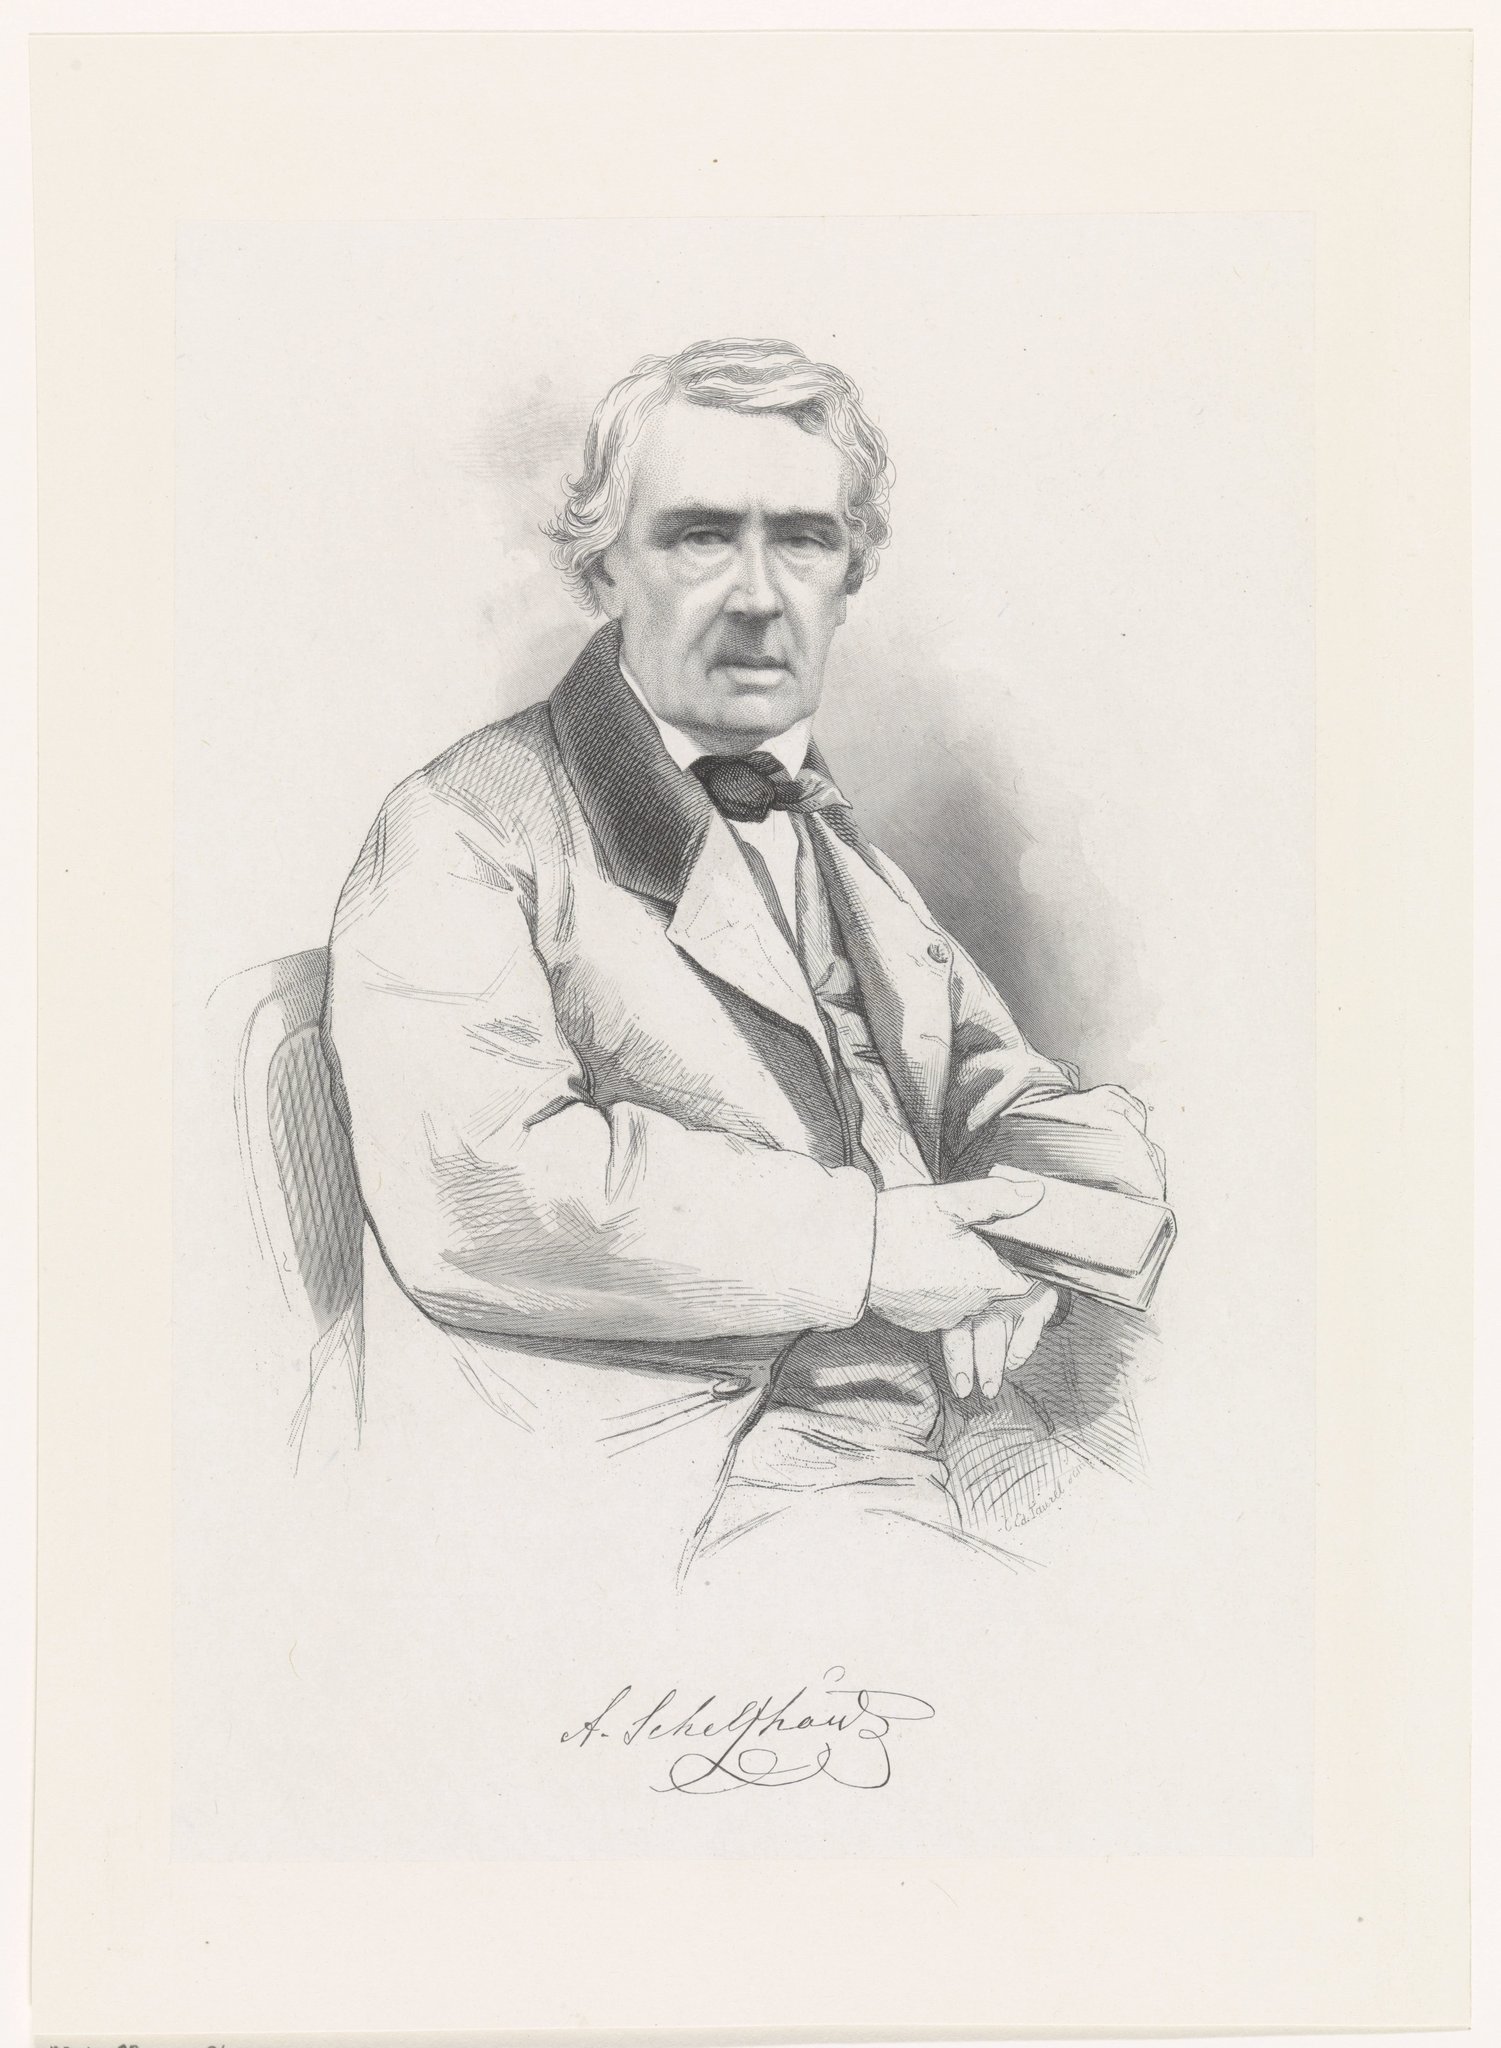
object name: print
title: Portret van Andreas Schelfhout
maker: edouard taurel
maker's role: draughtsman, print maker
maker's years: 1824-1892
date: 1867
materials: paper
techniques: engraving, etching, roulette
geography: amsterdam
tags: the hague, painter, print maker, draughtsman, andreas schelfhout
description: Prent ook gebruikt als illustratie in: T. van Westrheene. Kunstkronijk. Uitgegeven ter aanmoediging en bevordering der schoone kunsten, 1867.